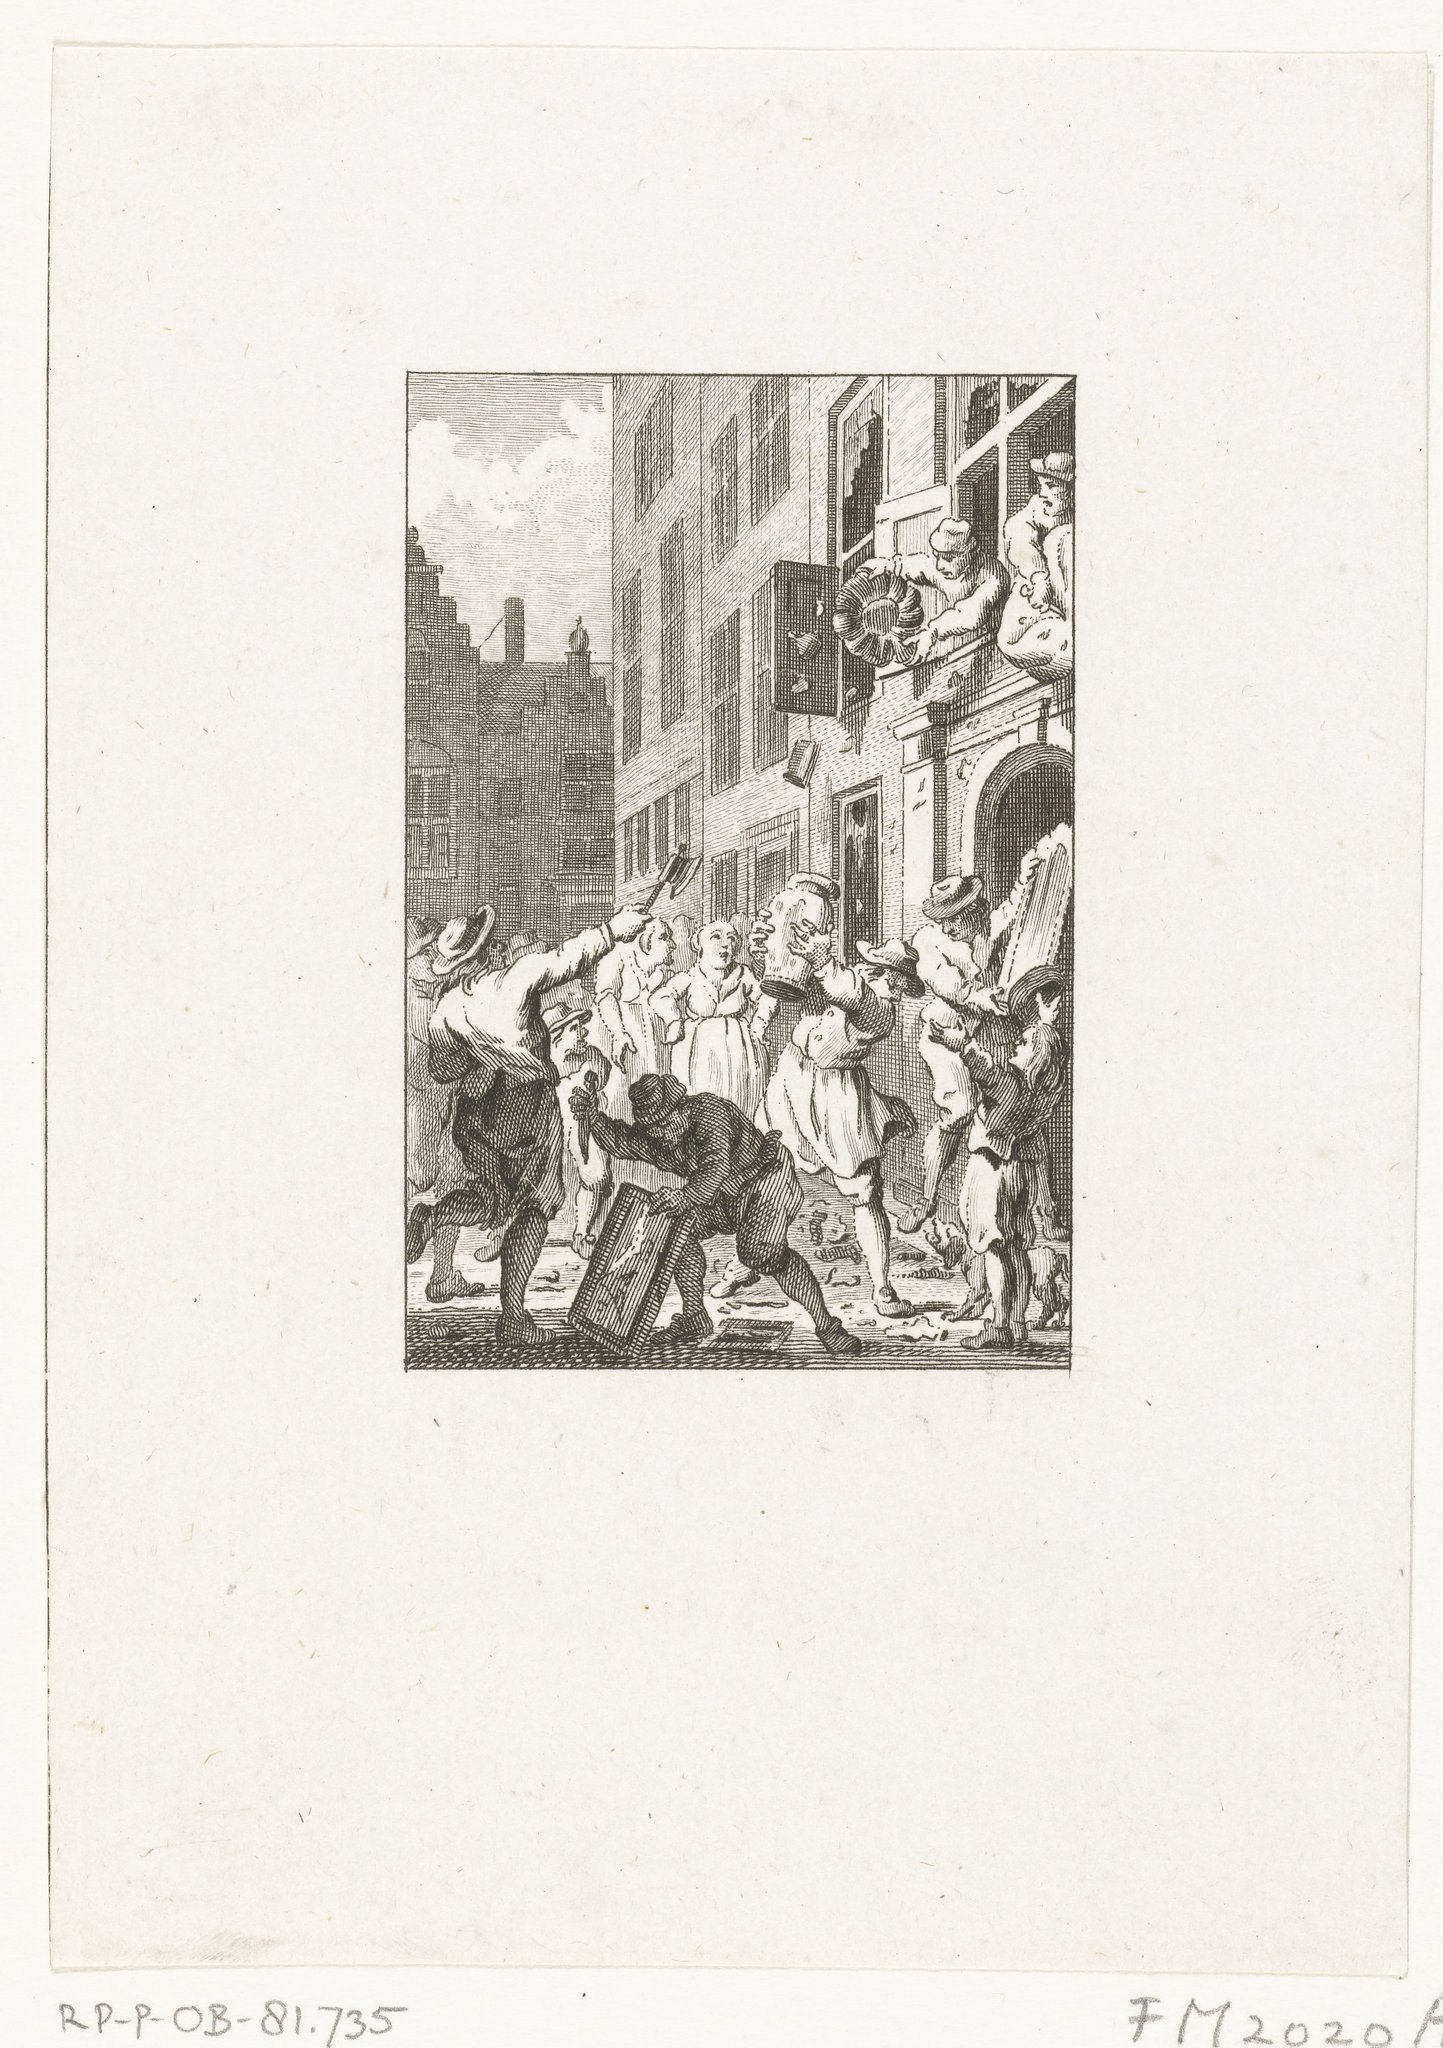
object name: history print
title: Oproer te Middelburg en het plunderen van het huis van burgemeester Lansbergen, 1651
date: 1780-1795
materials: paper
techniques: etching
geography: netherlands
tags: plundering ~ riot, middelburg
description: Oproer te Middelburg en het plunderen van het huis van burgemeester Jacobus Lansbergen, juli 1651. Plunderaars gooien het huisraad uit het huis van de burgemeester op straat, wegens zijn Orangistische sympathieën voor de jonge prins Willem III.